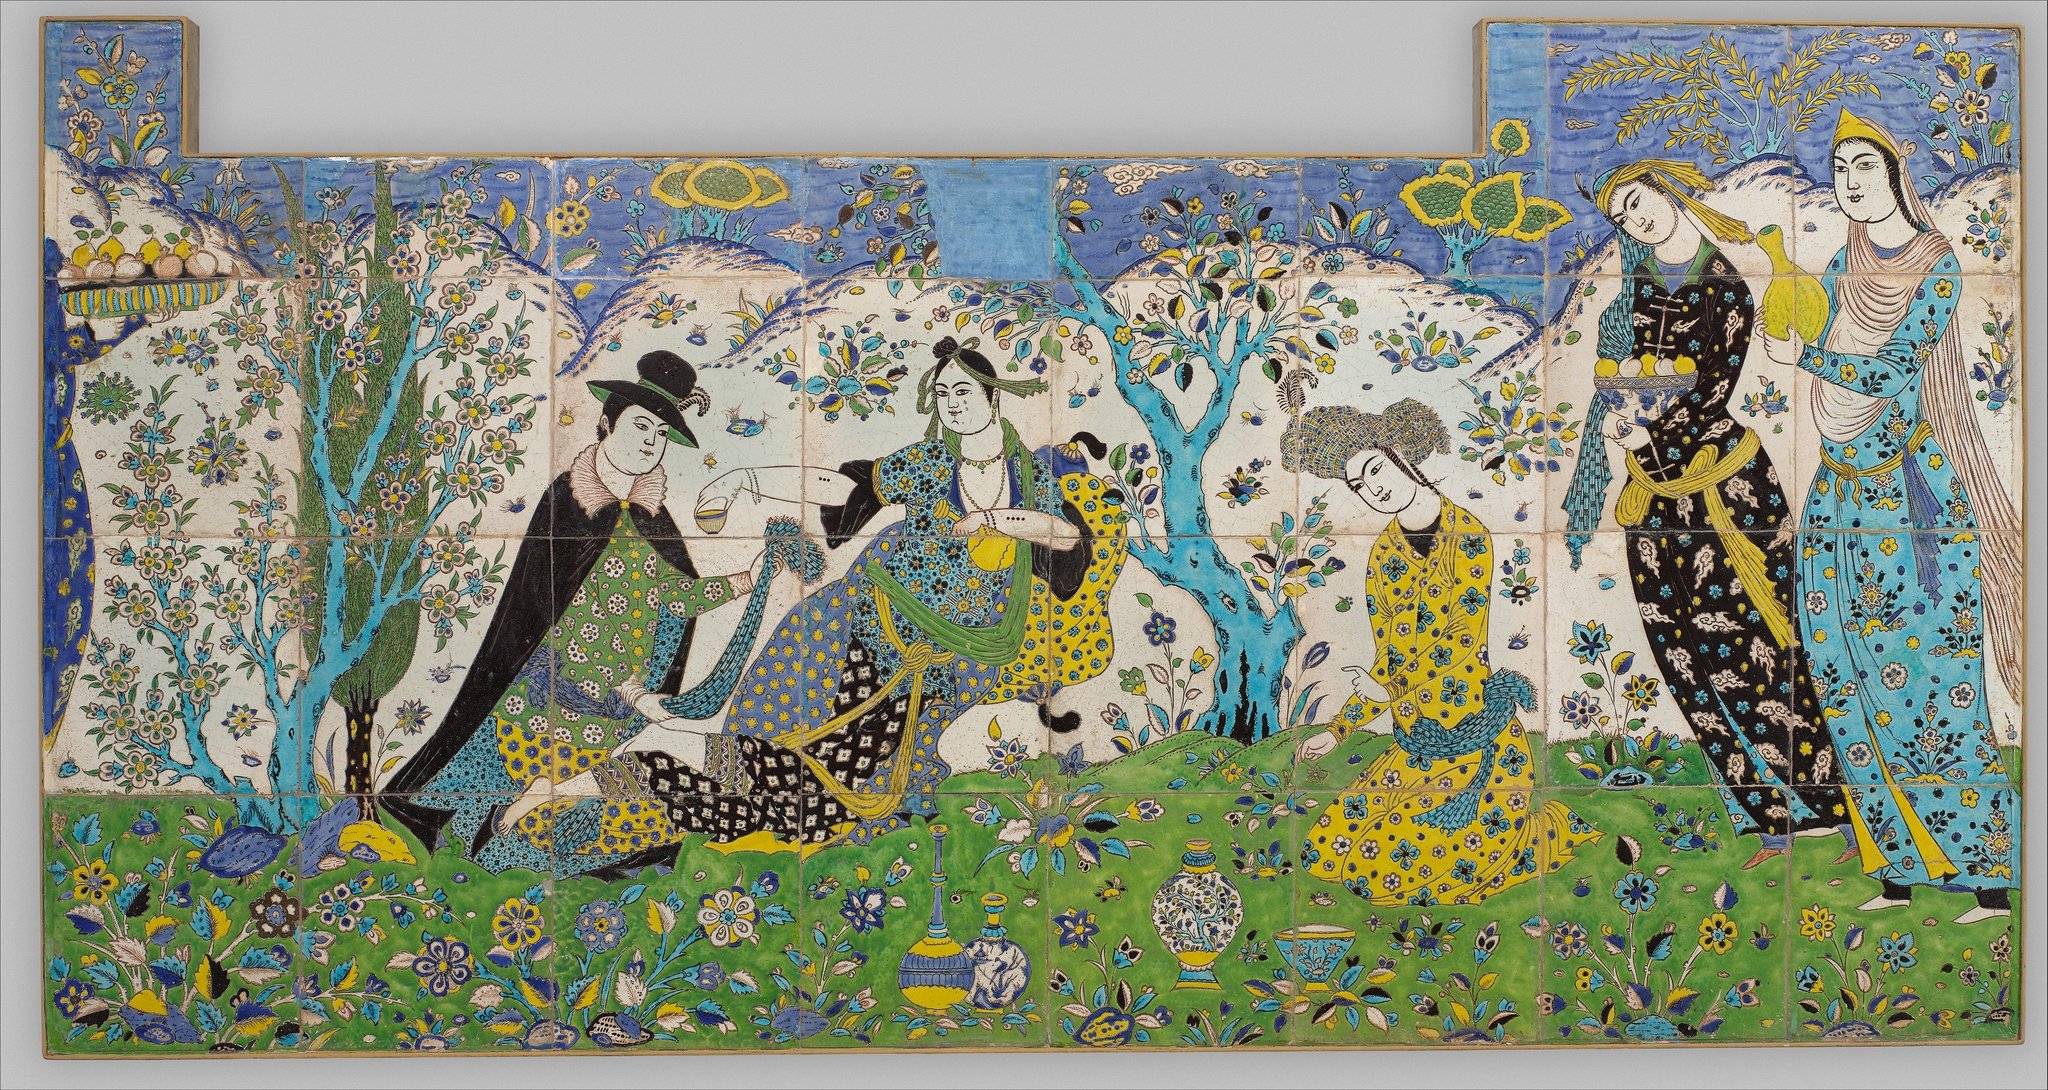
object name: tile panel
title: Garden Gathering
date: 1640-1650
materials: stonepaste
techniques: glazing, painting, polychrome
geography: iran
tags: gardens,men,women,flowers,trees